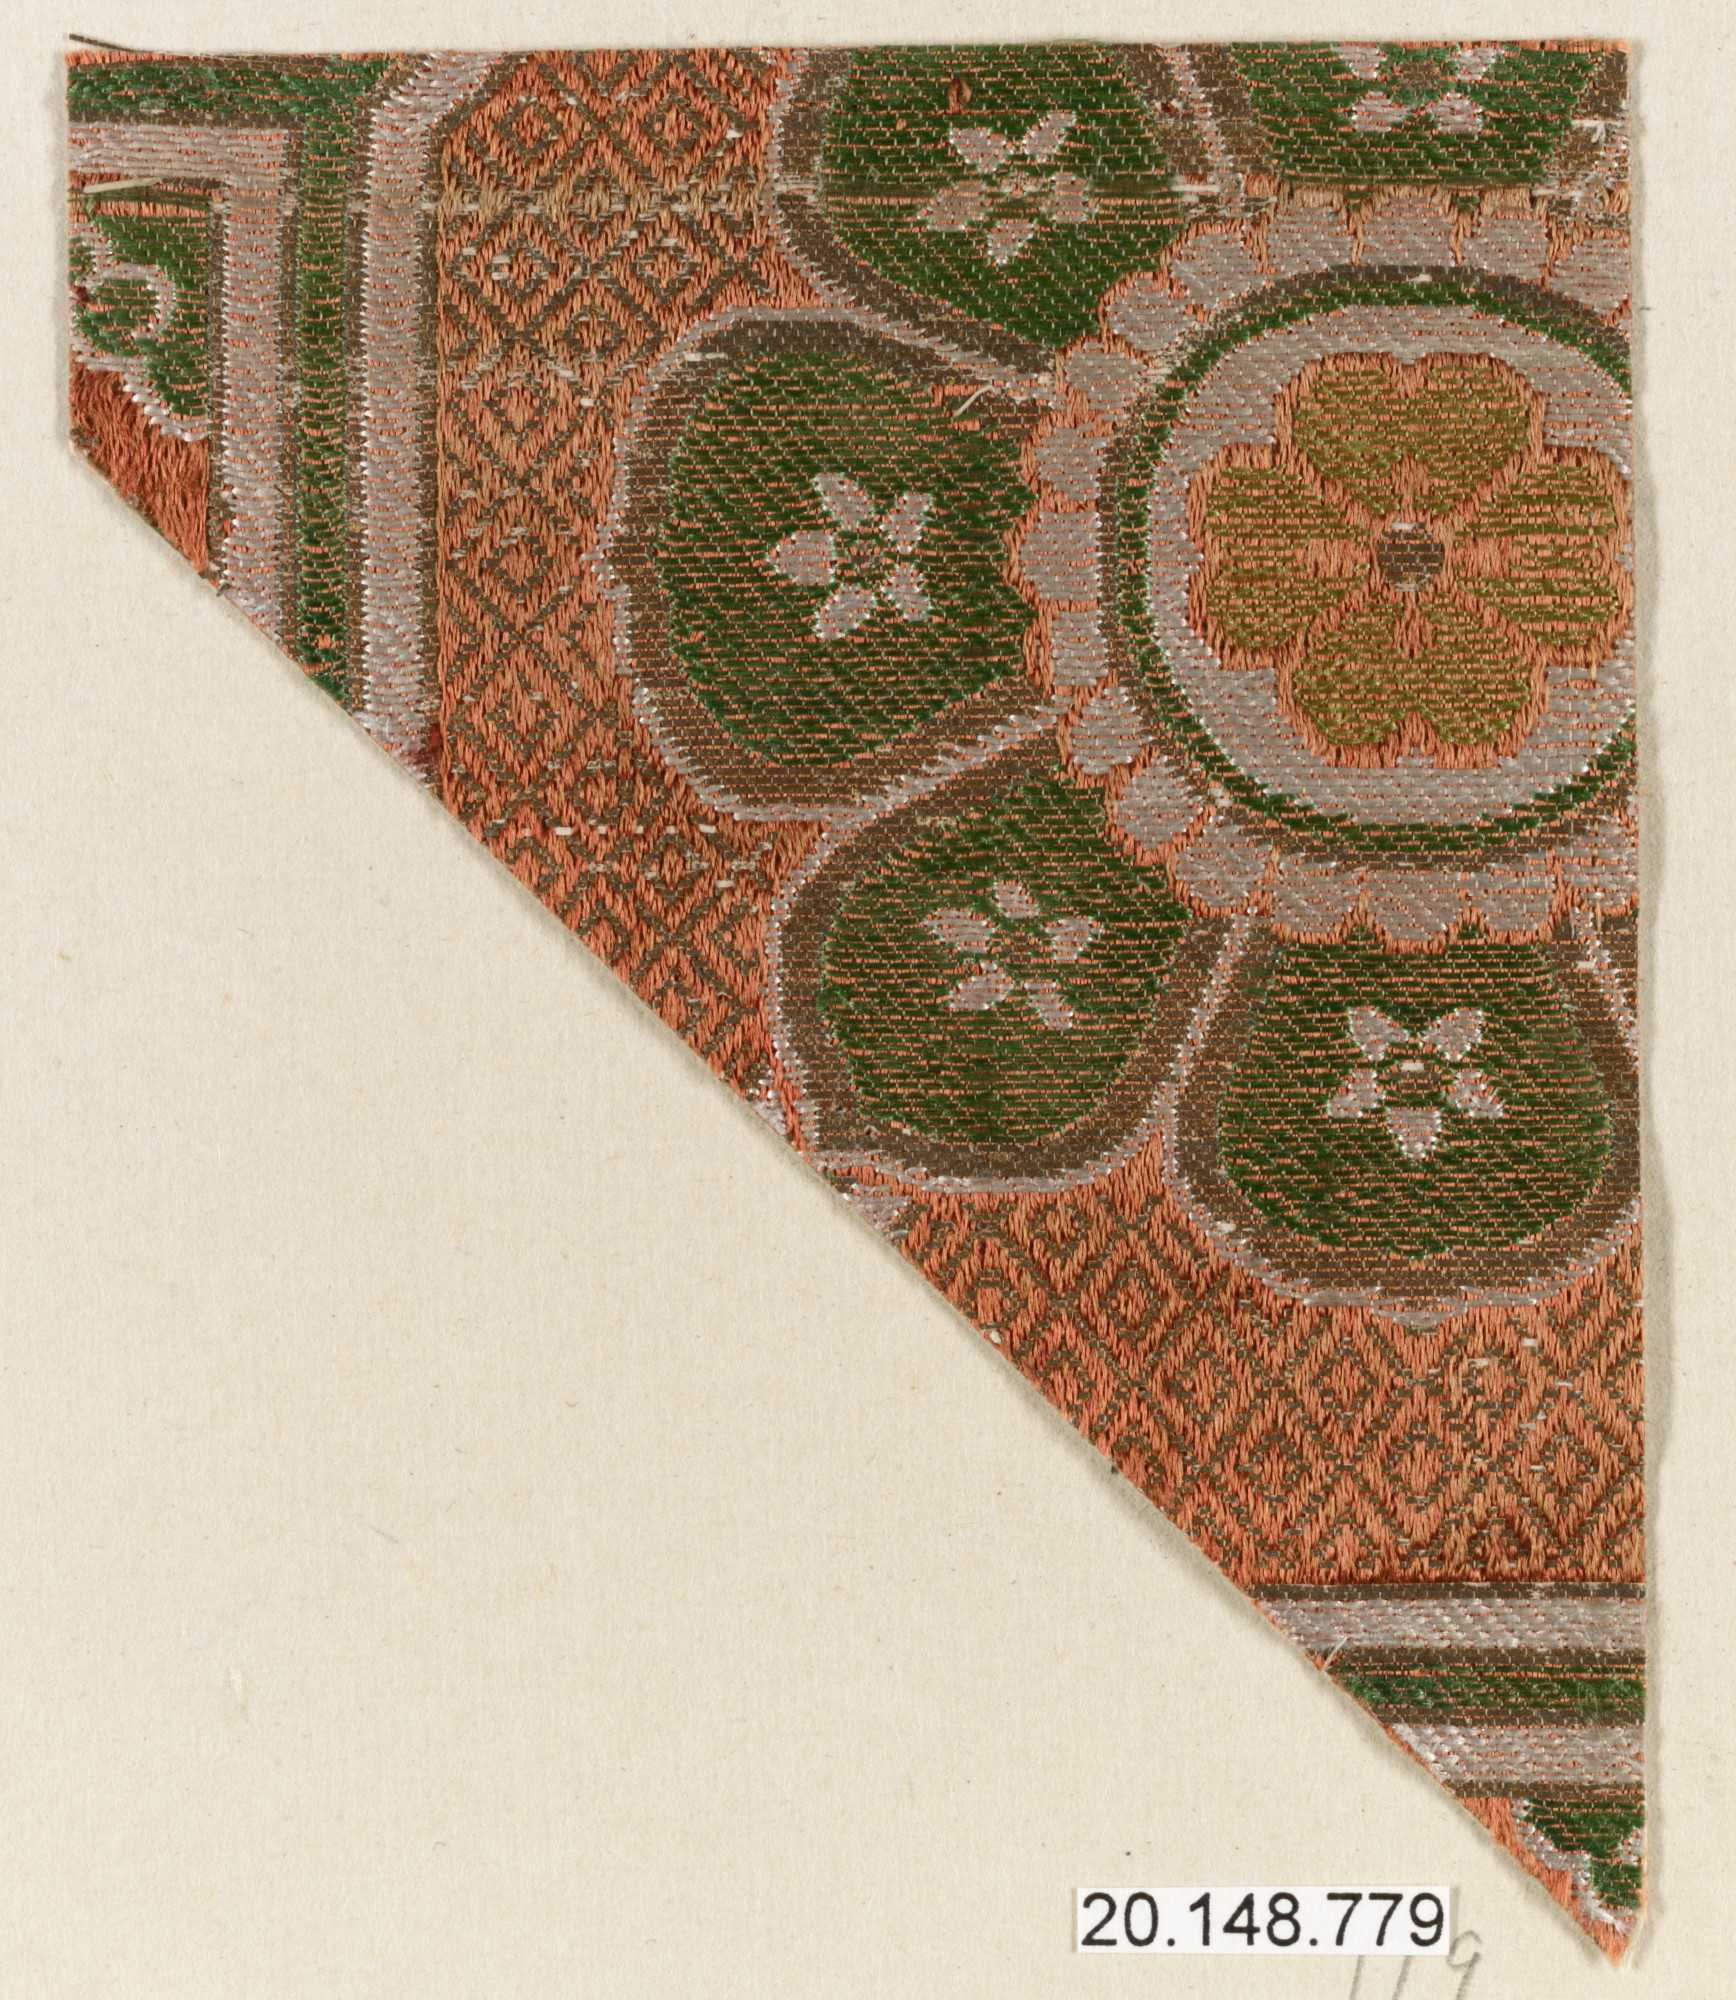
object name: piece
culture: japanese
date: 1601-1700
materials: silk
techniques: compound weave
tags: flowers